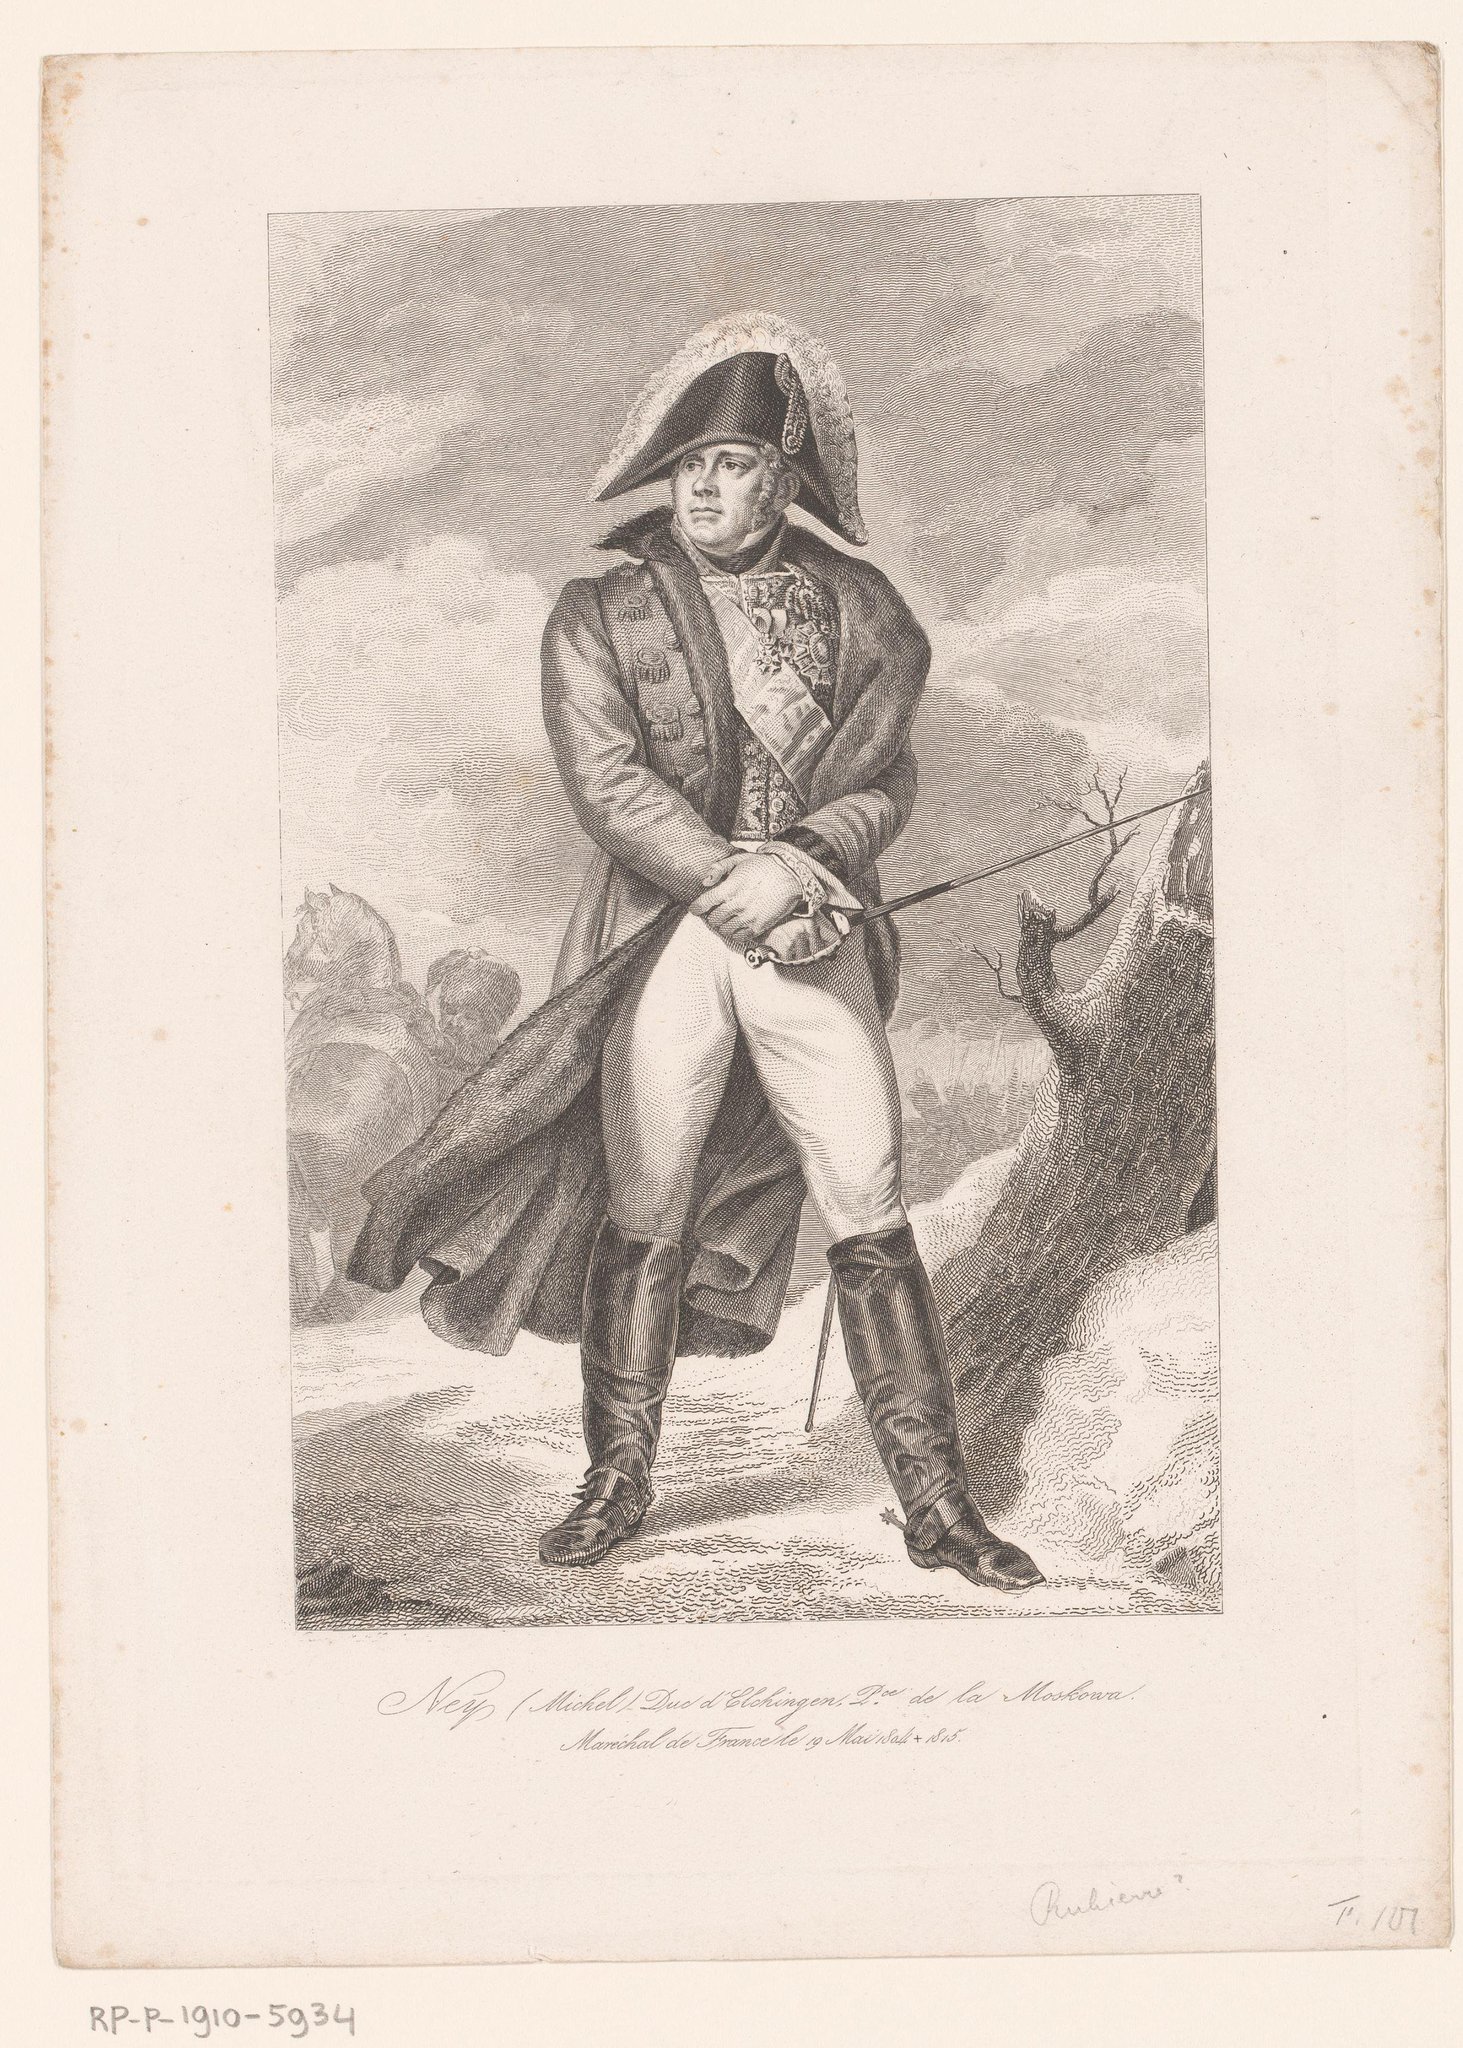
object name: book illustration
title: Ney (Michel) Duc d'Elchingen, Pce de la Mouskowa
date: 1838-1841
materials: paper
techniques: etching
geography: paris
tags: paris, commander-in-chief, general, marshal, historical persons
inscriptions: collector's mark: Lugt 2228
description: Prent uit: s.n. Galeries historiques de Versailles. Parijs: Charles Gavard, 1838-1841.